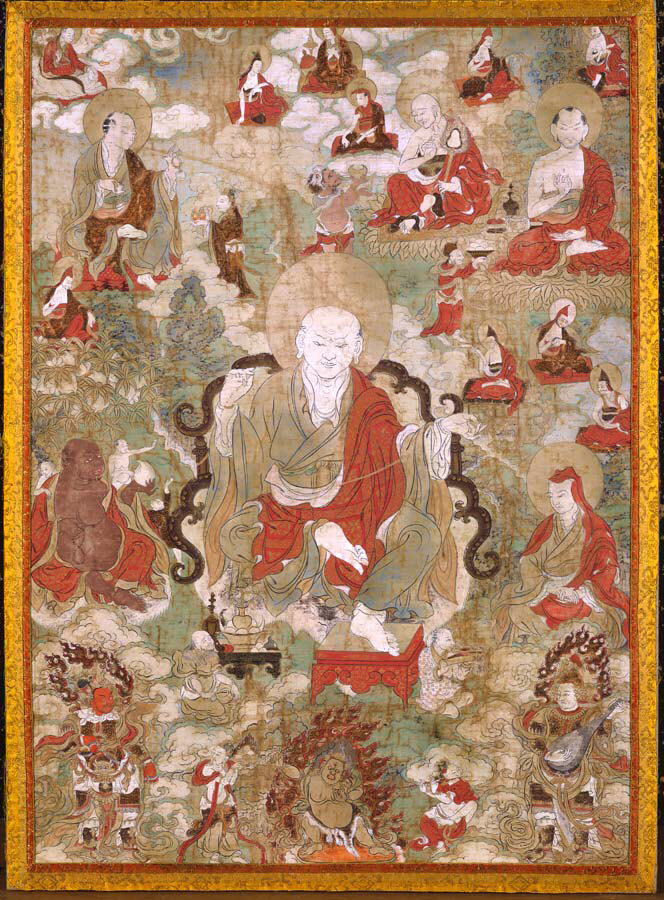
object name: triptych panel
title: Luohan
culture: chinese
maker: unidentified artist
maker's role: artist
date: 1368-1644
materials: linen, panel, watercolor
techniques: painting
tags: men,buddhism